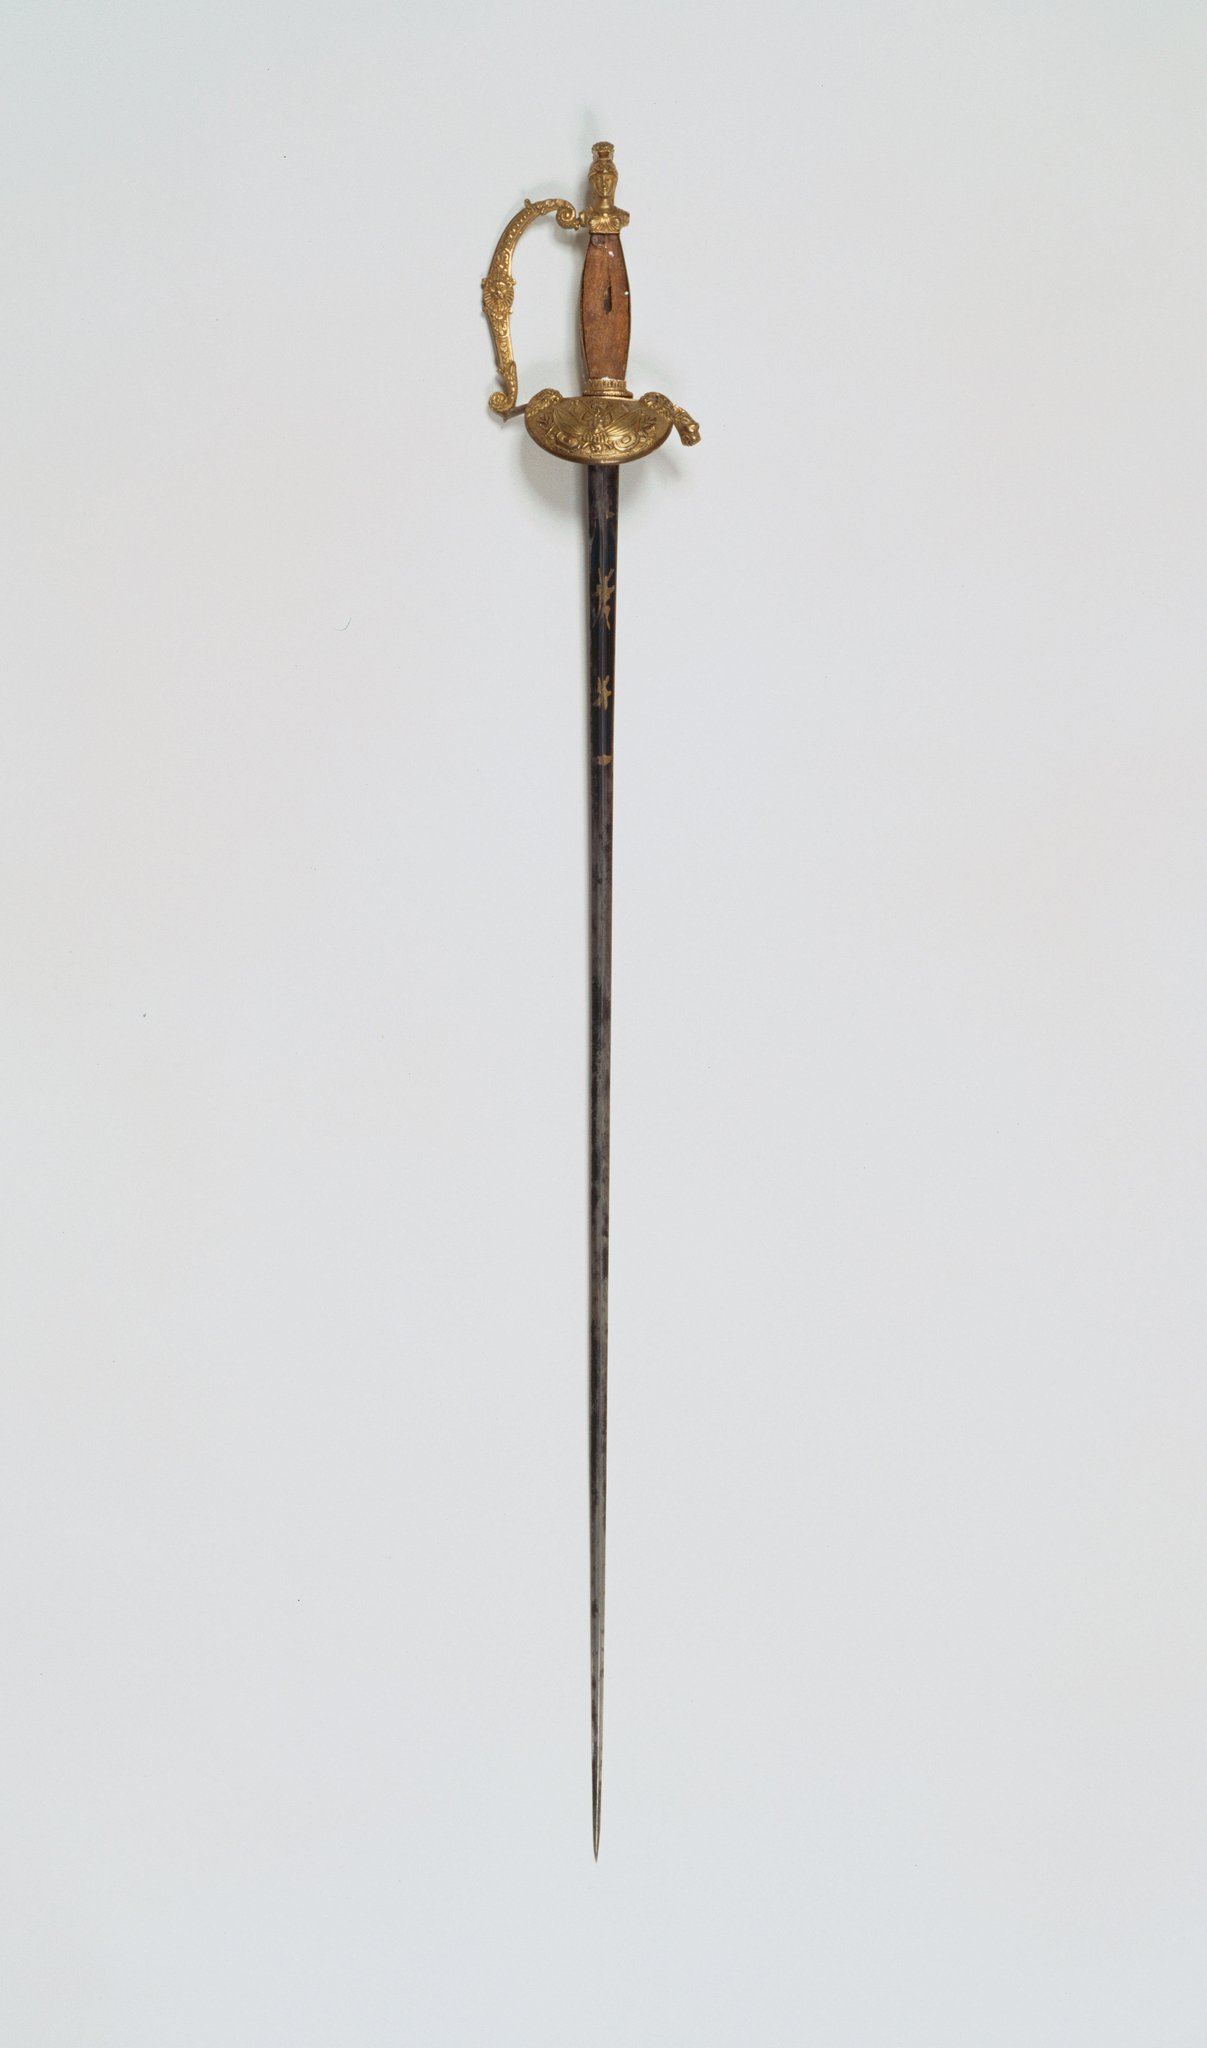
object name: sword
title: Degen van Jhr. J.M. de Bosch Kemper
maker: Anonymous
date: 1810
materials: copper, gold, iron, mother of pearl, wood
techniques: amalgam gilded, etching, forging, sawing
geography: netherlands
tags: jonkheer j.m. de bosch kemper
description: Degen met vuurverguld koperen gevest, Lodewijk XVI stijl. Knop in de vorm van een vrouwernbuste met helm. Geornamenteerde voorbeugel, o.a. met leeuwenkoppen. Een parelmoeren plaat aan deels metalen greep. Halve pareerstang met leeuwenkop. Stootplaat met wapentrofee en leeuwenkoppen. Achterzijde: kleine stootplaat met leeuwenkop. Driezijdig geblauwde en vuurvergulde geëtste kling. Gedragen door Jhr. J.M. de Bosch Kemper.